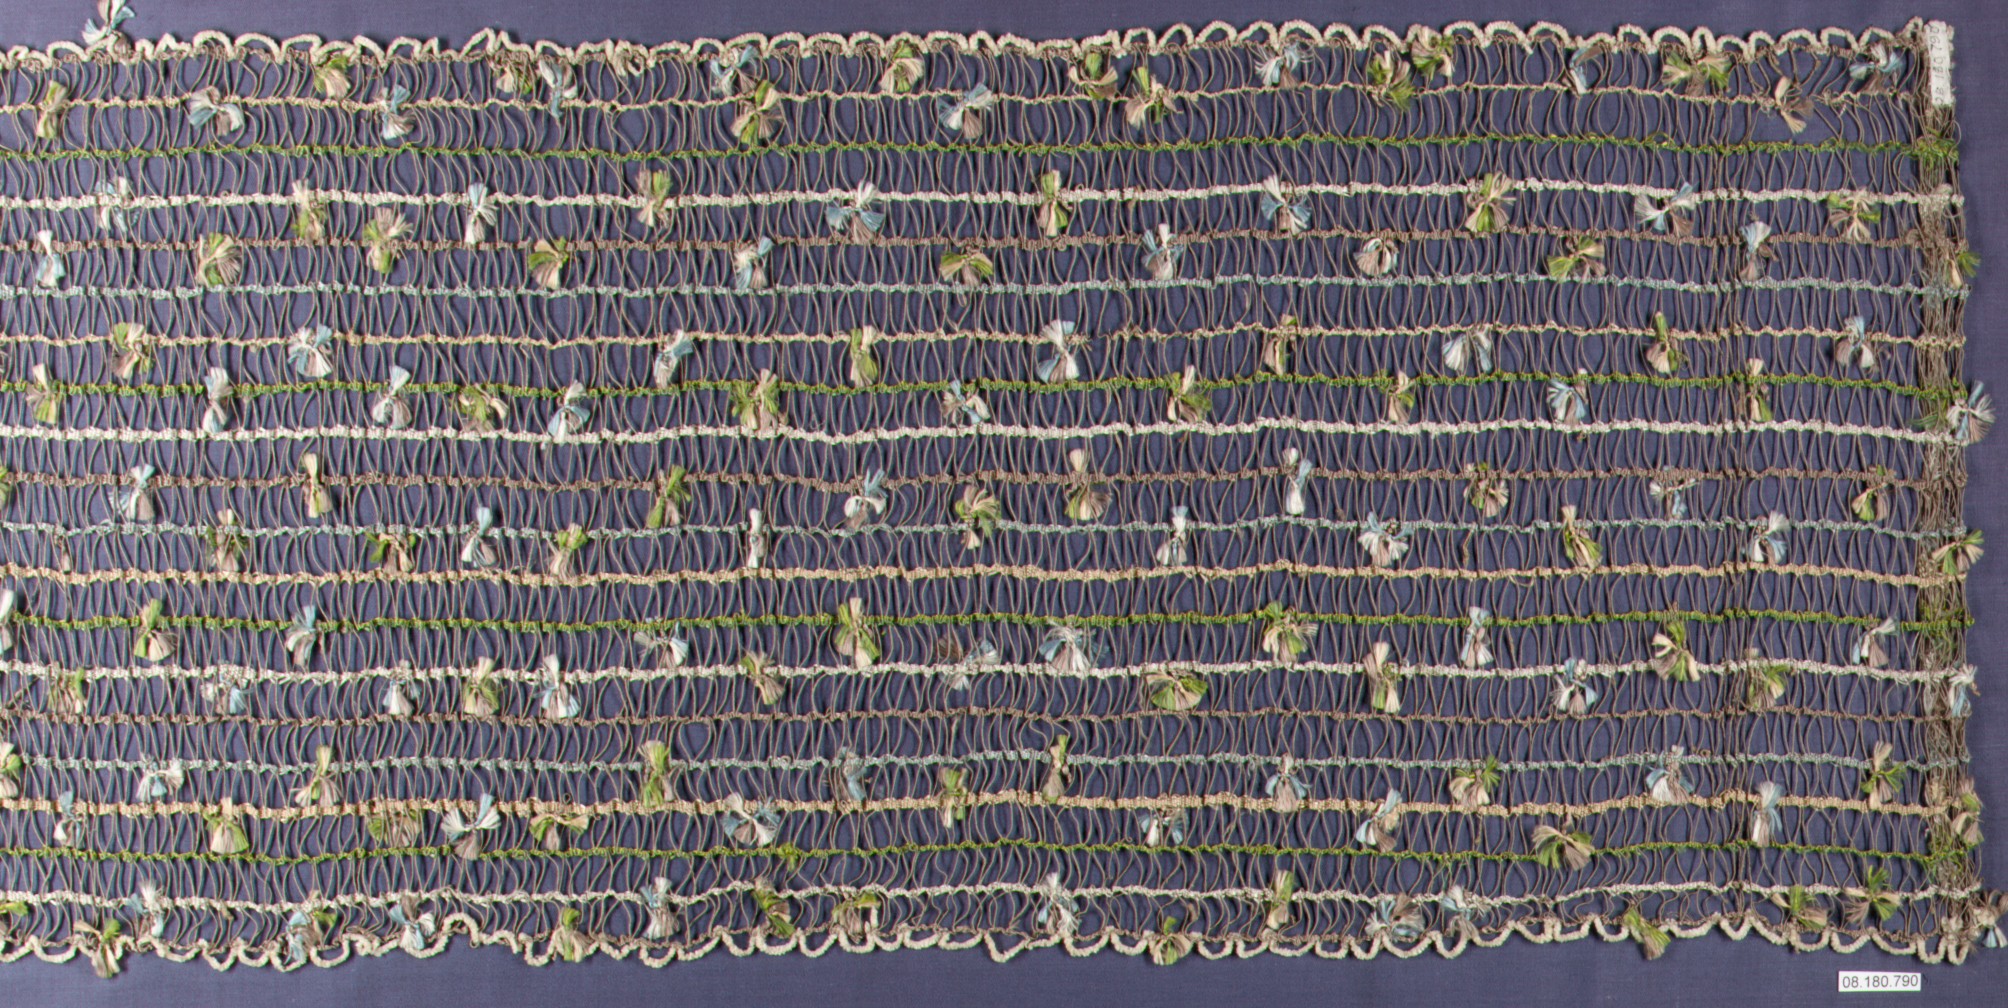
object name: passementerie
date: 1701-1800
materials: silk